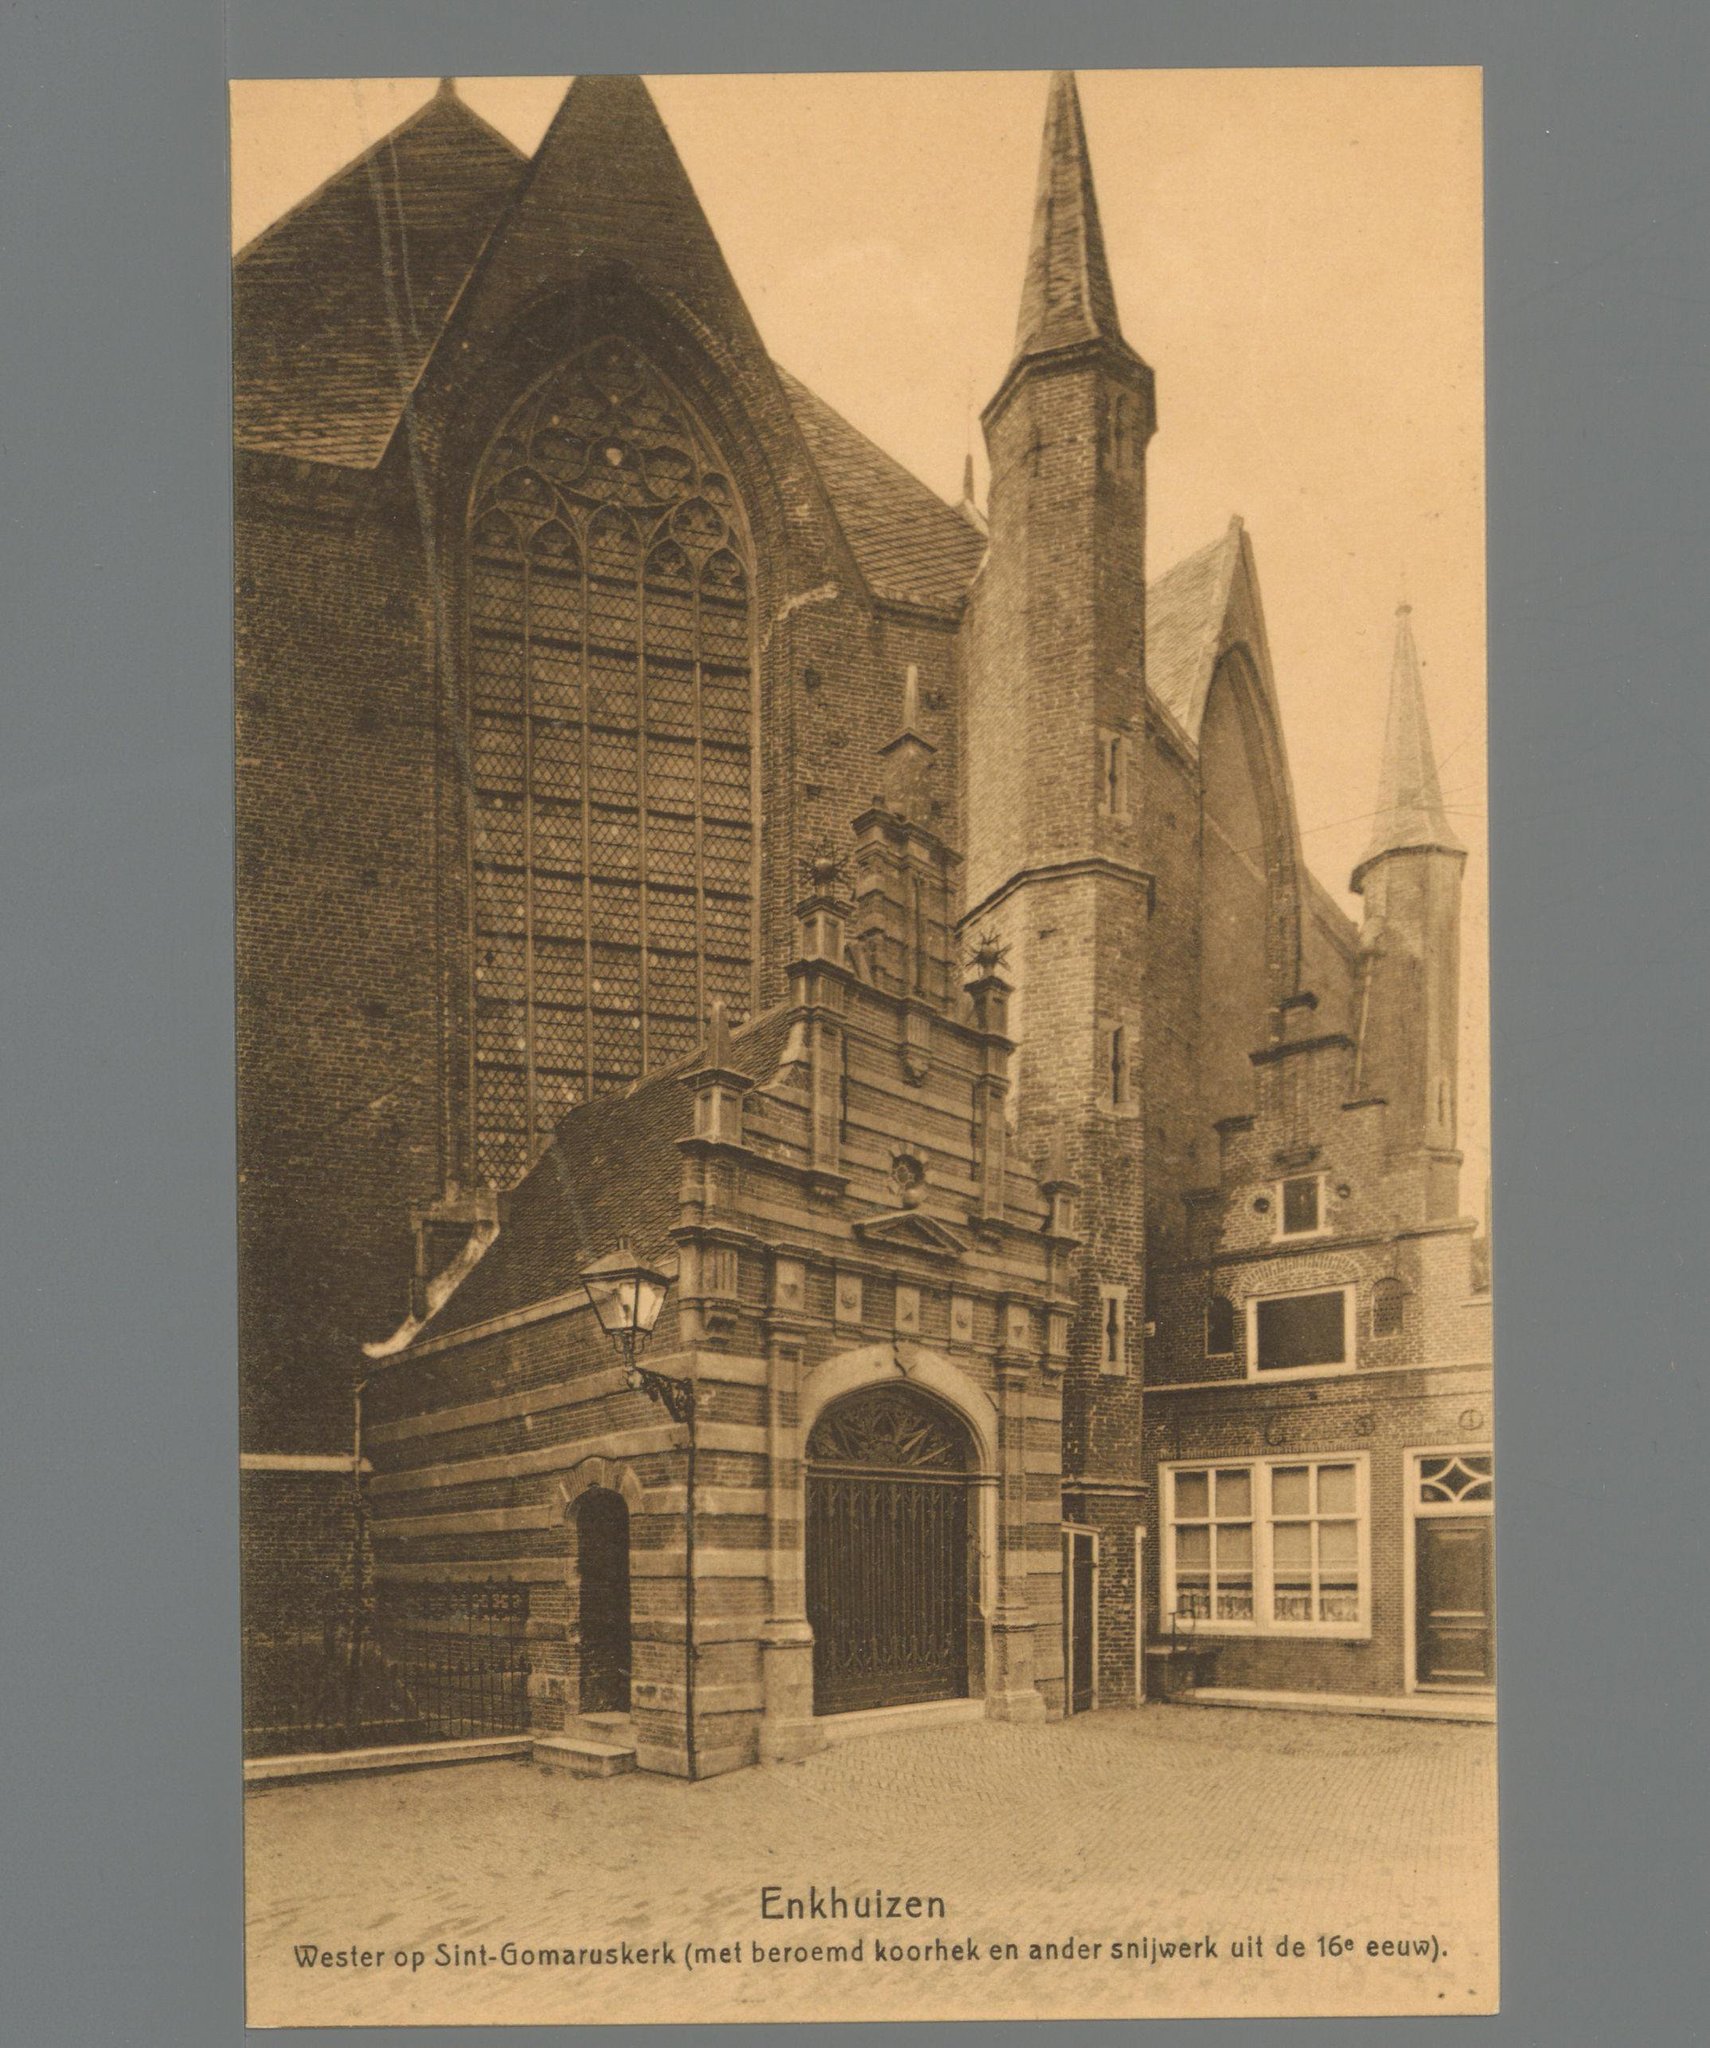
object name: ansichtkaart, prentbriefkaart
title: Enkhuizen. Wester op Sint-Gomaruskerk (met beroemd koorhek en ander snijwerk uit de 16e eeuw)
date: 1906-1920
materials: cardboard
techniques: photograph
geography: enkhuizen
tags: church (exterior), enkhuizen